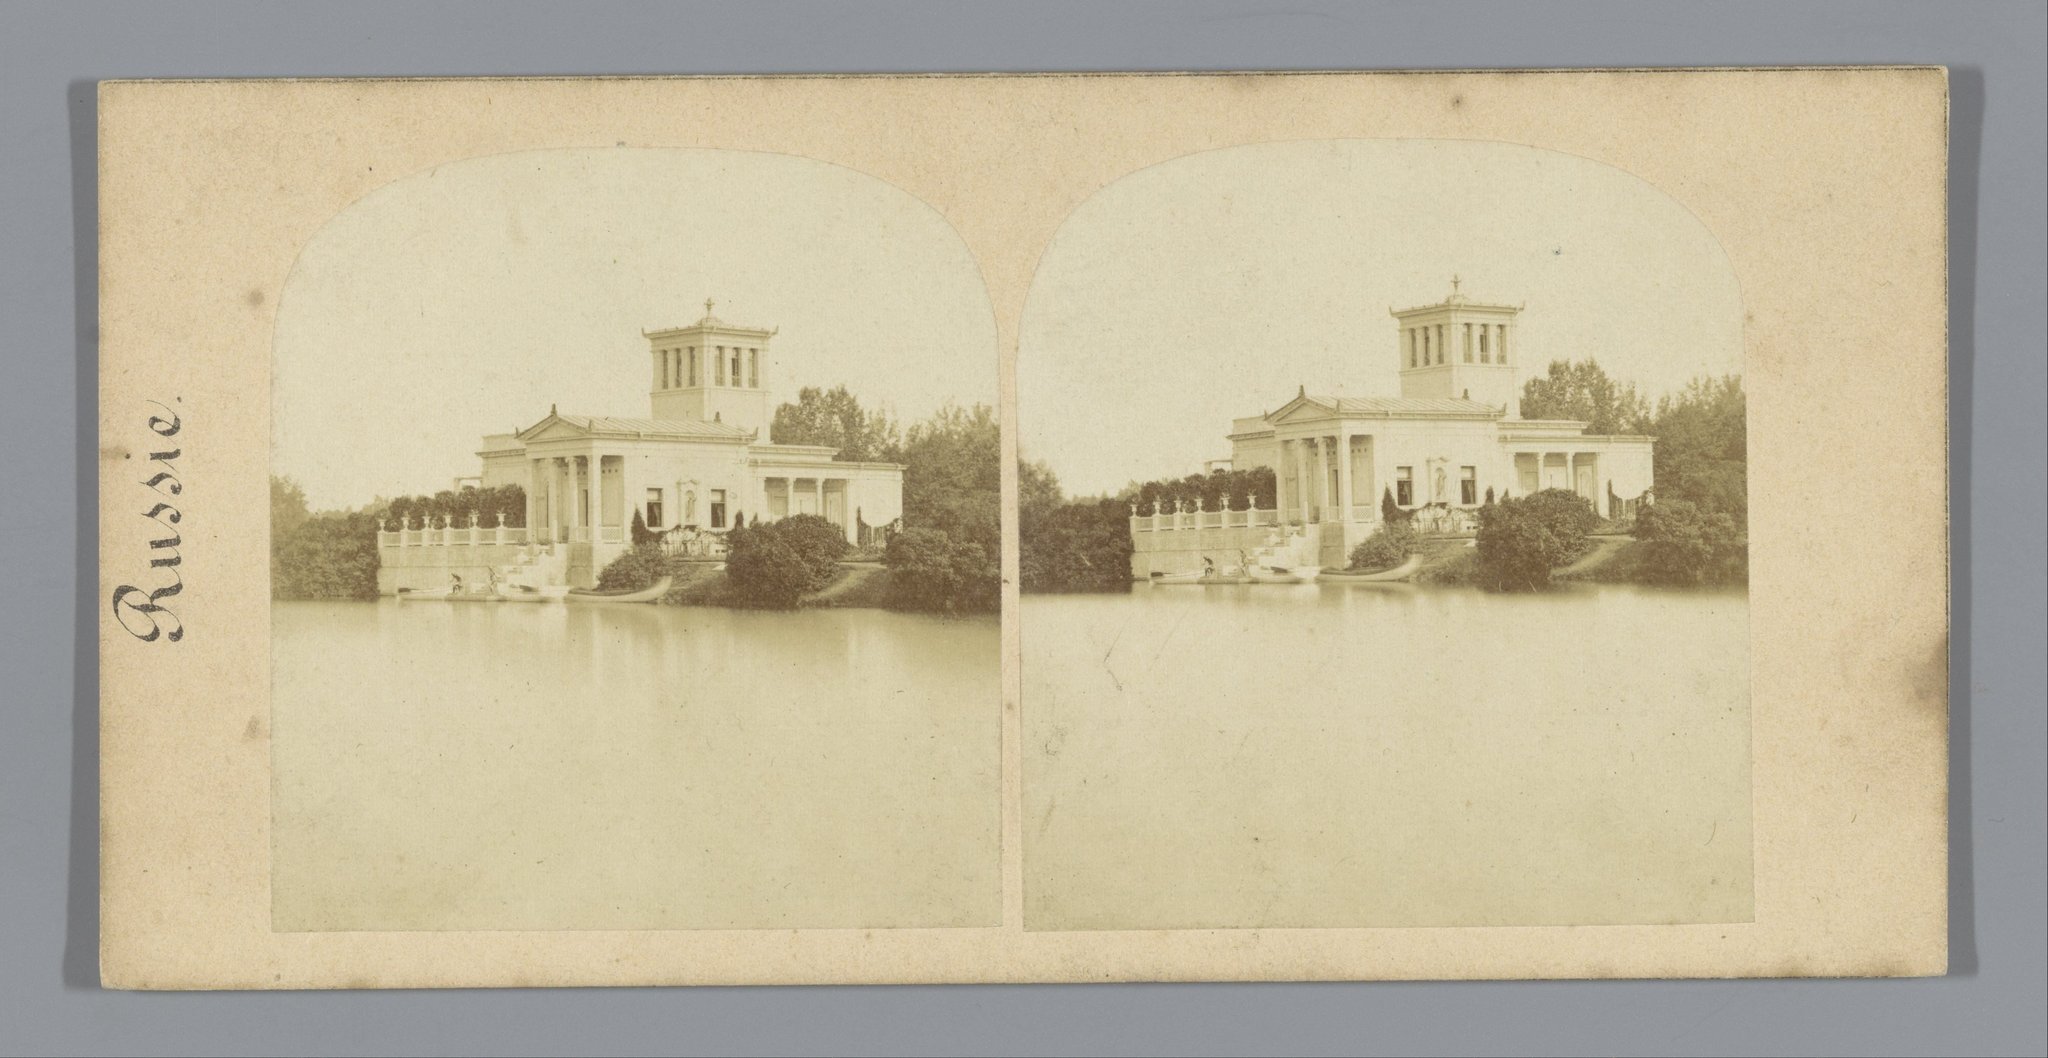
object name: stereograph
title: Eiland in een vijver bij het Paleizencomplex van Peter de Grote I in Peterhof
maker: Anonymous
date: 1850-1880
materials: cardboard, photographic support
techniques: albumen print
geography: peterhof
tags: island, palace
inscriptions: inscription: ‘No 26 Ile de l'Impératrice Peterhoff St. Petersburg’, inscription: ‘Russie.’